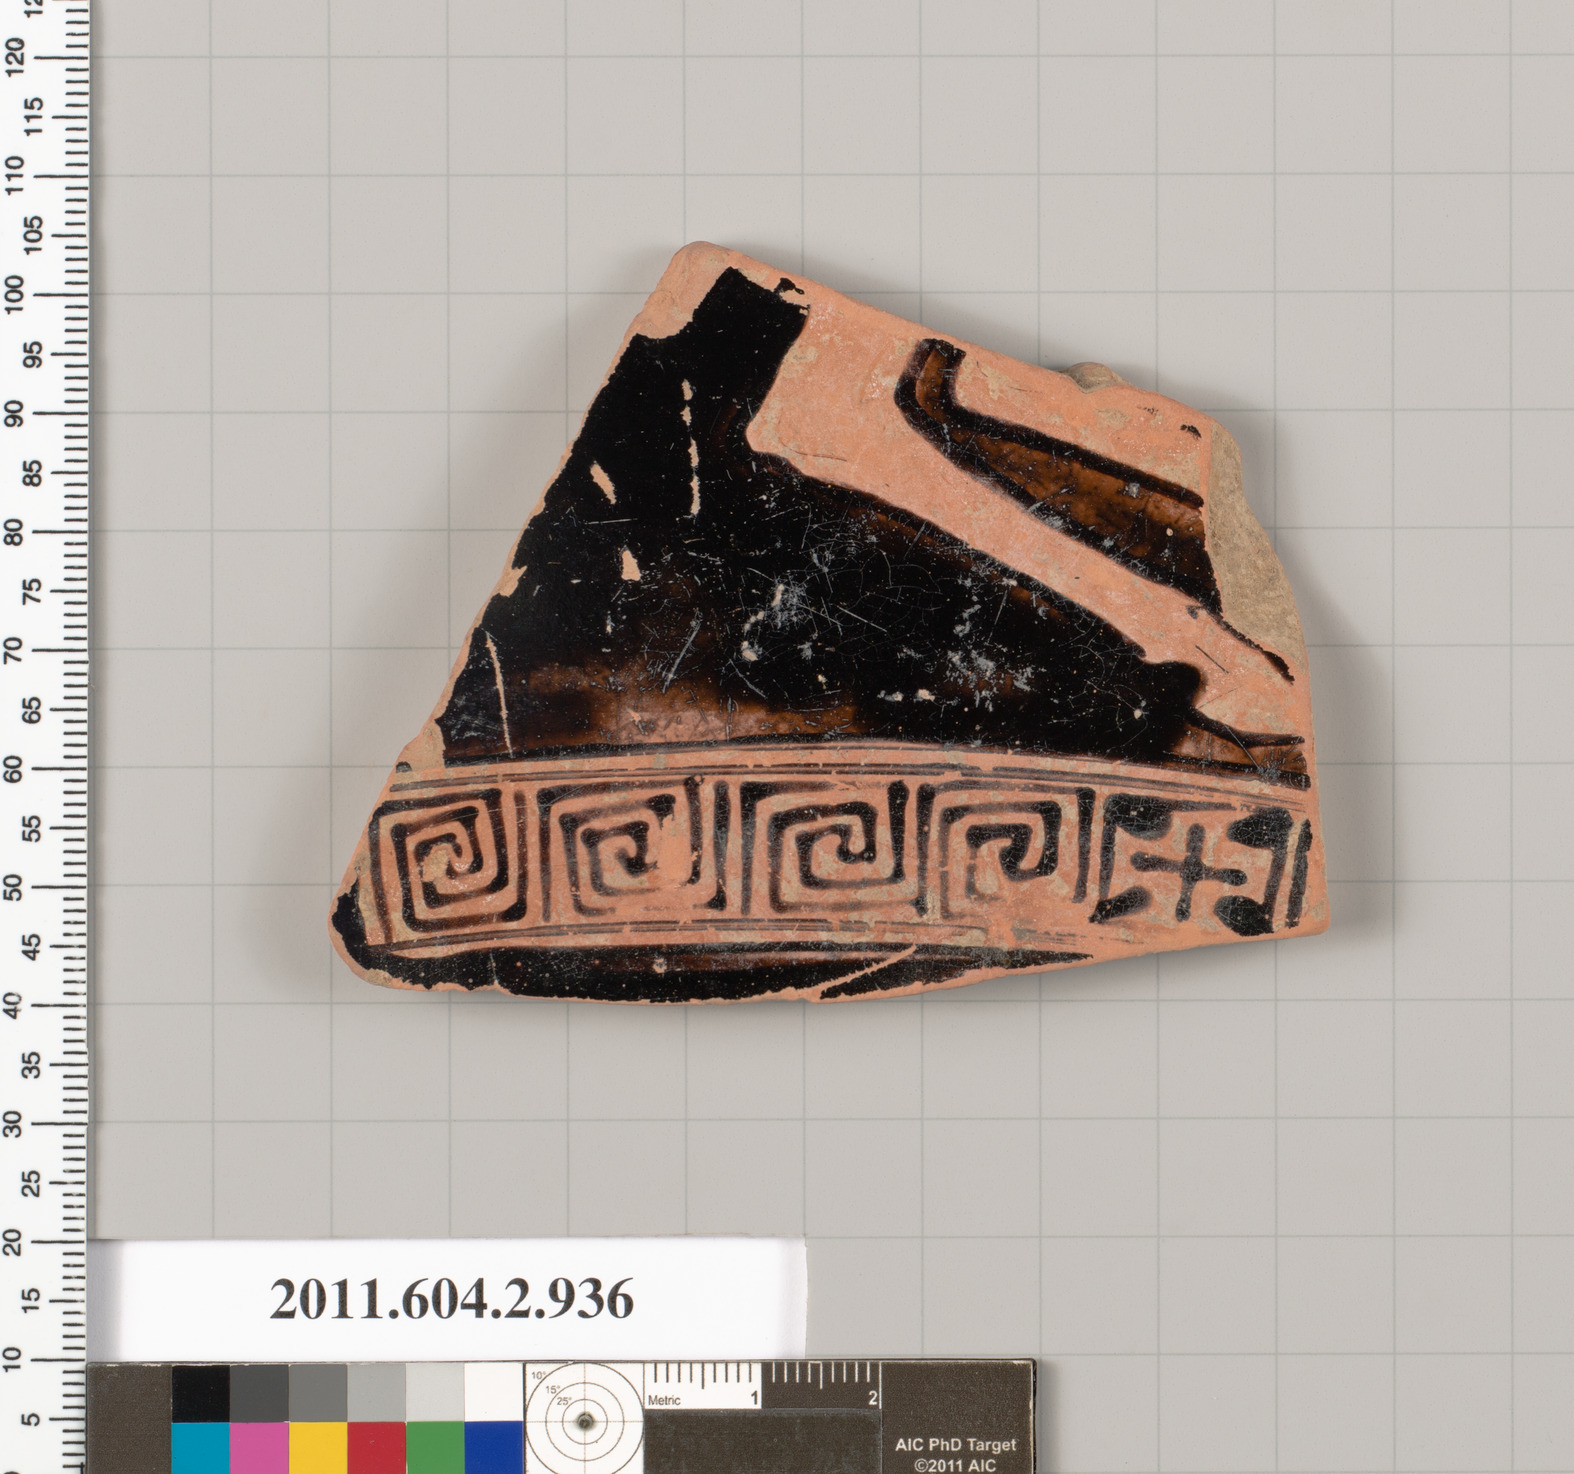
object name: bell krater fragment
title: Terracotta fragment of a bell-krater (bowl for mixing wine and water)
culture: greek, attic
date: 440-430 BCE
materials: terracotta